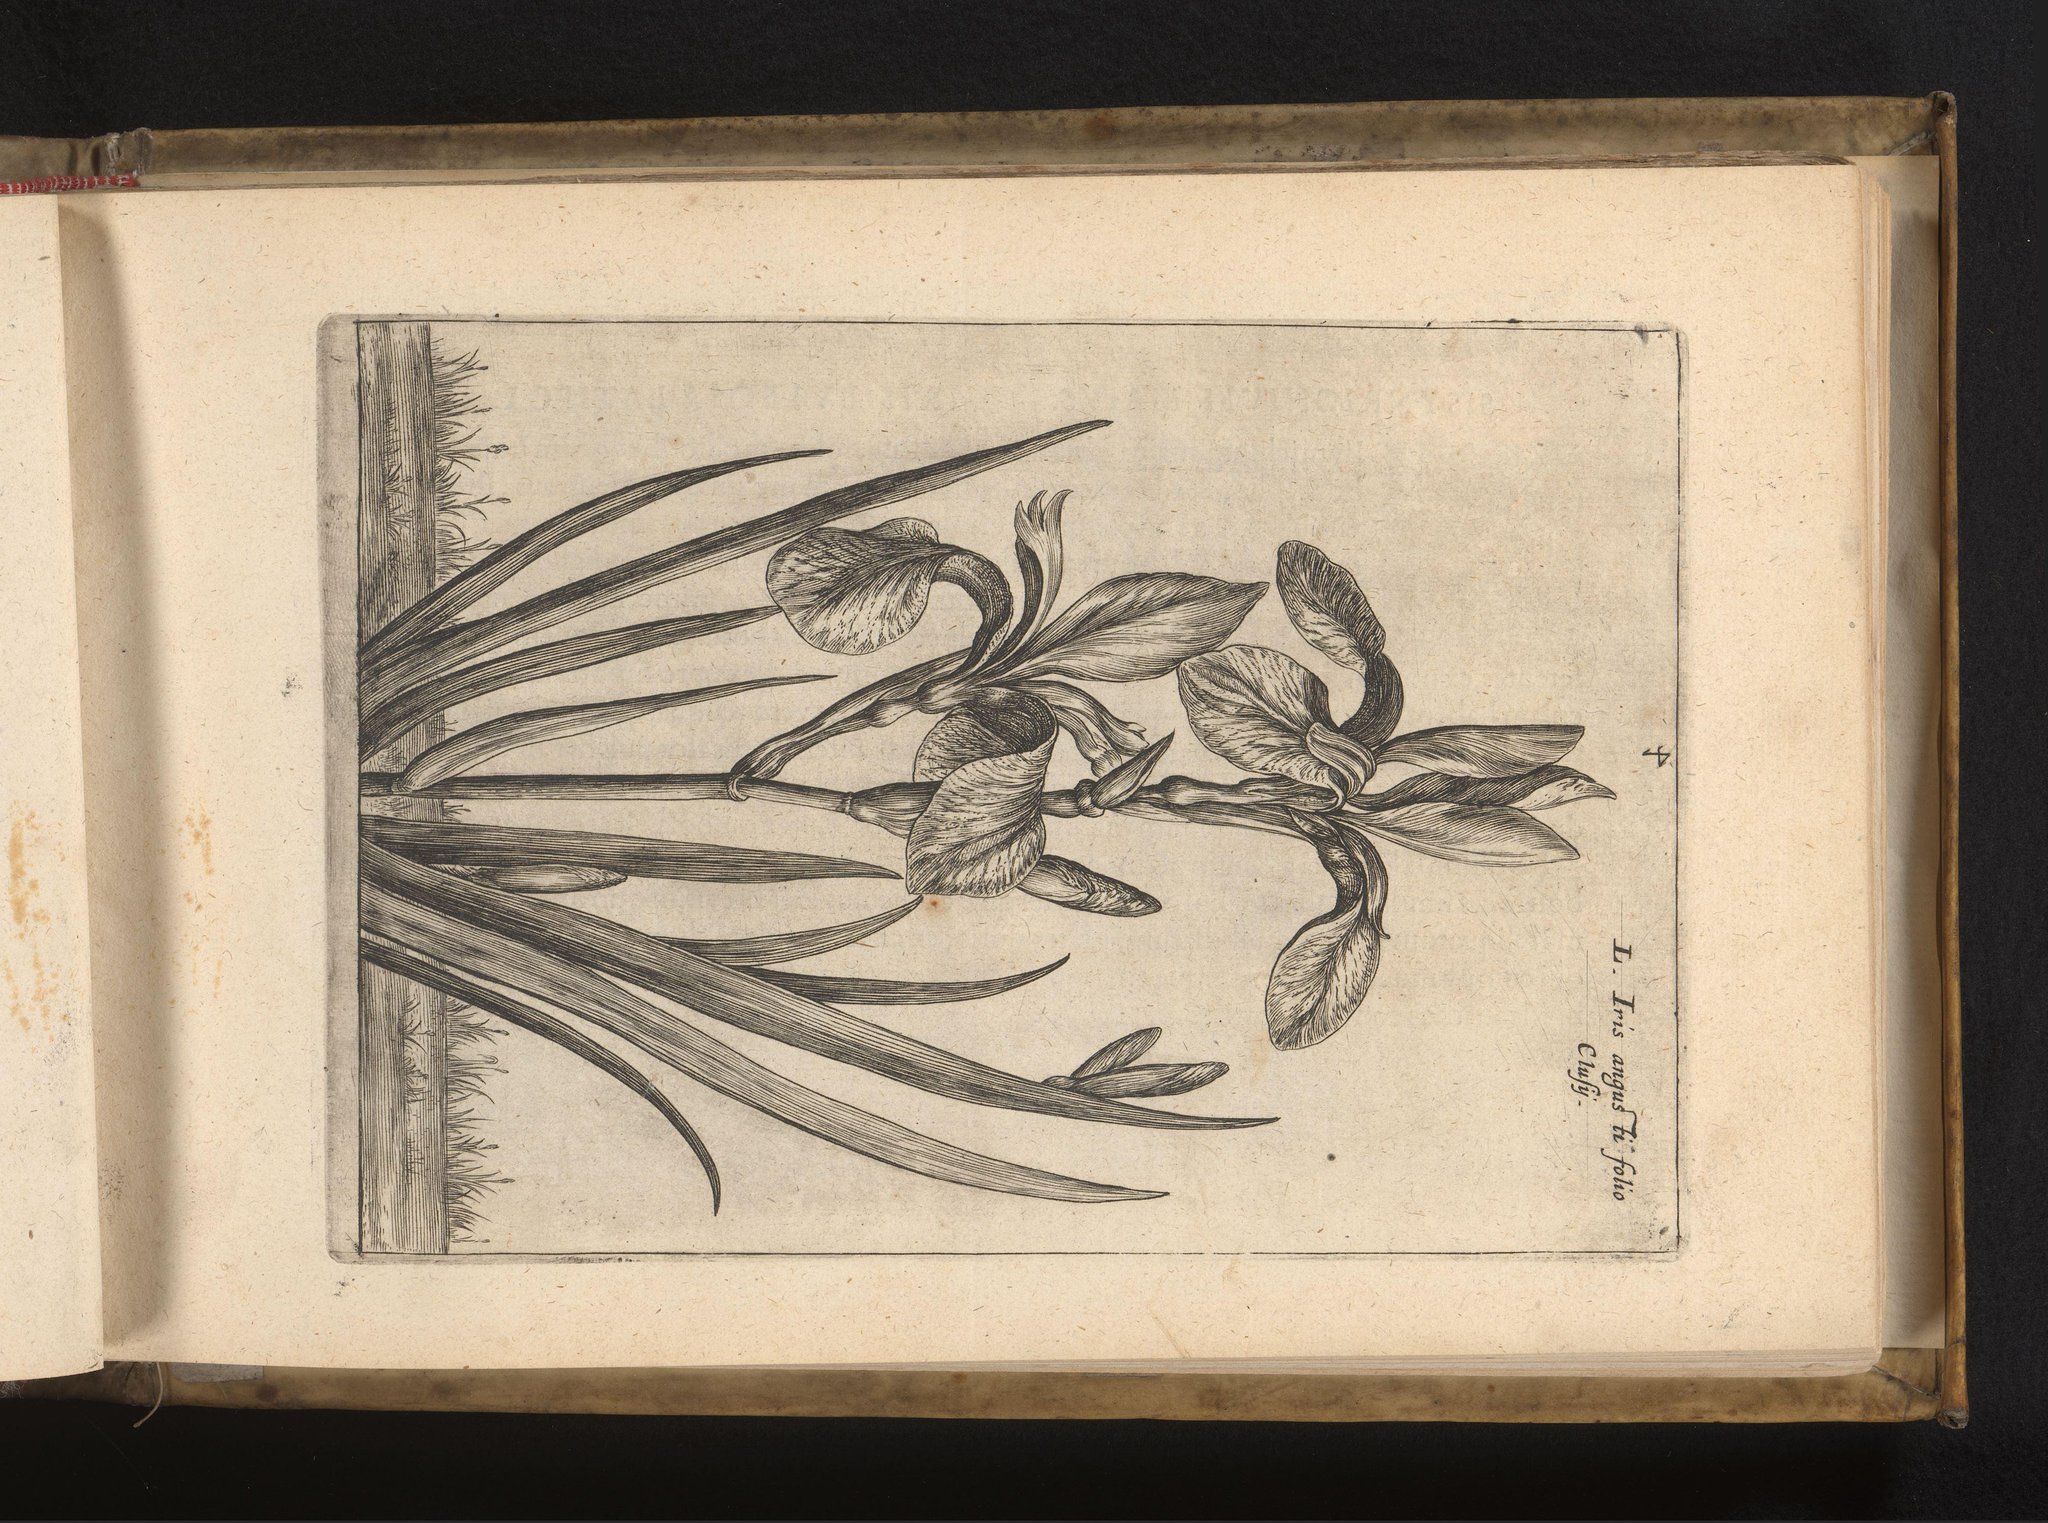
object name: print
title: Aestas horti floridi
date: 1617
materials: paper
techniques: engraving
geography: utrecht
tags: flowers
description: Prent uit: Passe, Crispijn van de (II). Hortus floridus in quo rariorum & minus vulgarium florum icones ad vivam veramque formam. Arnhem: Johannes Janssonius, 1617.